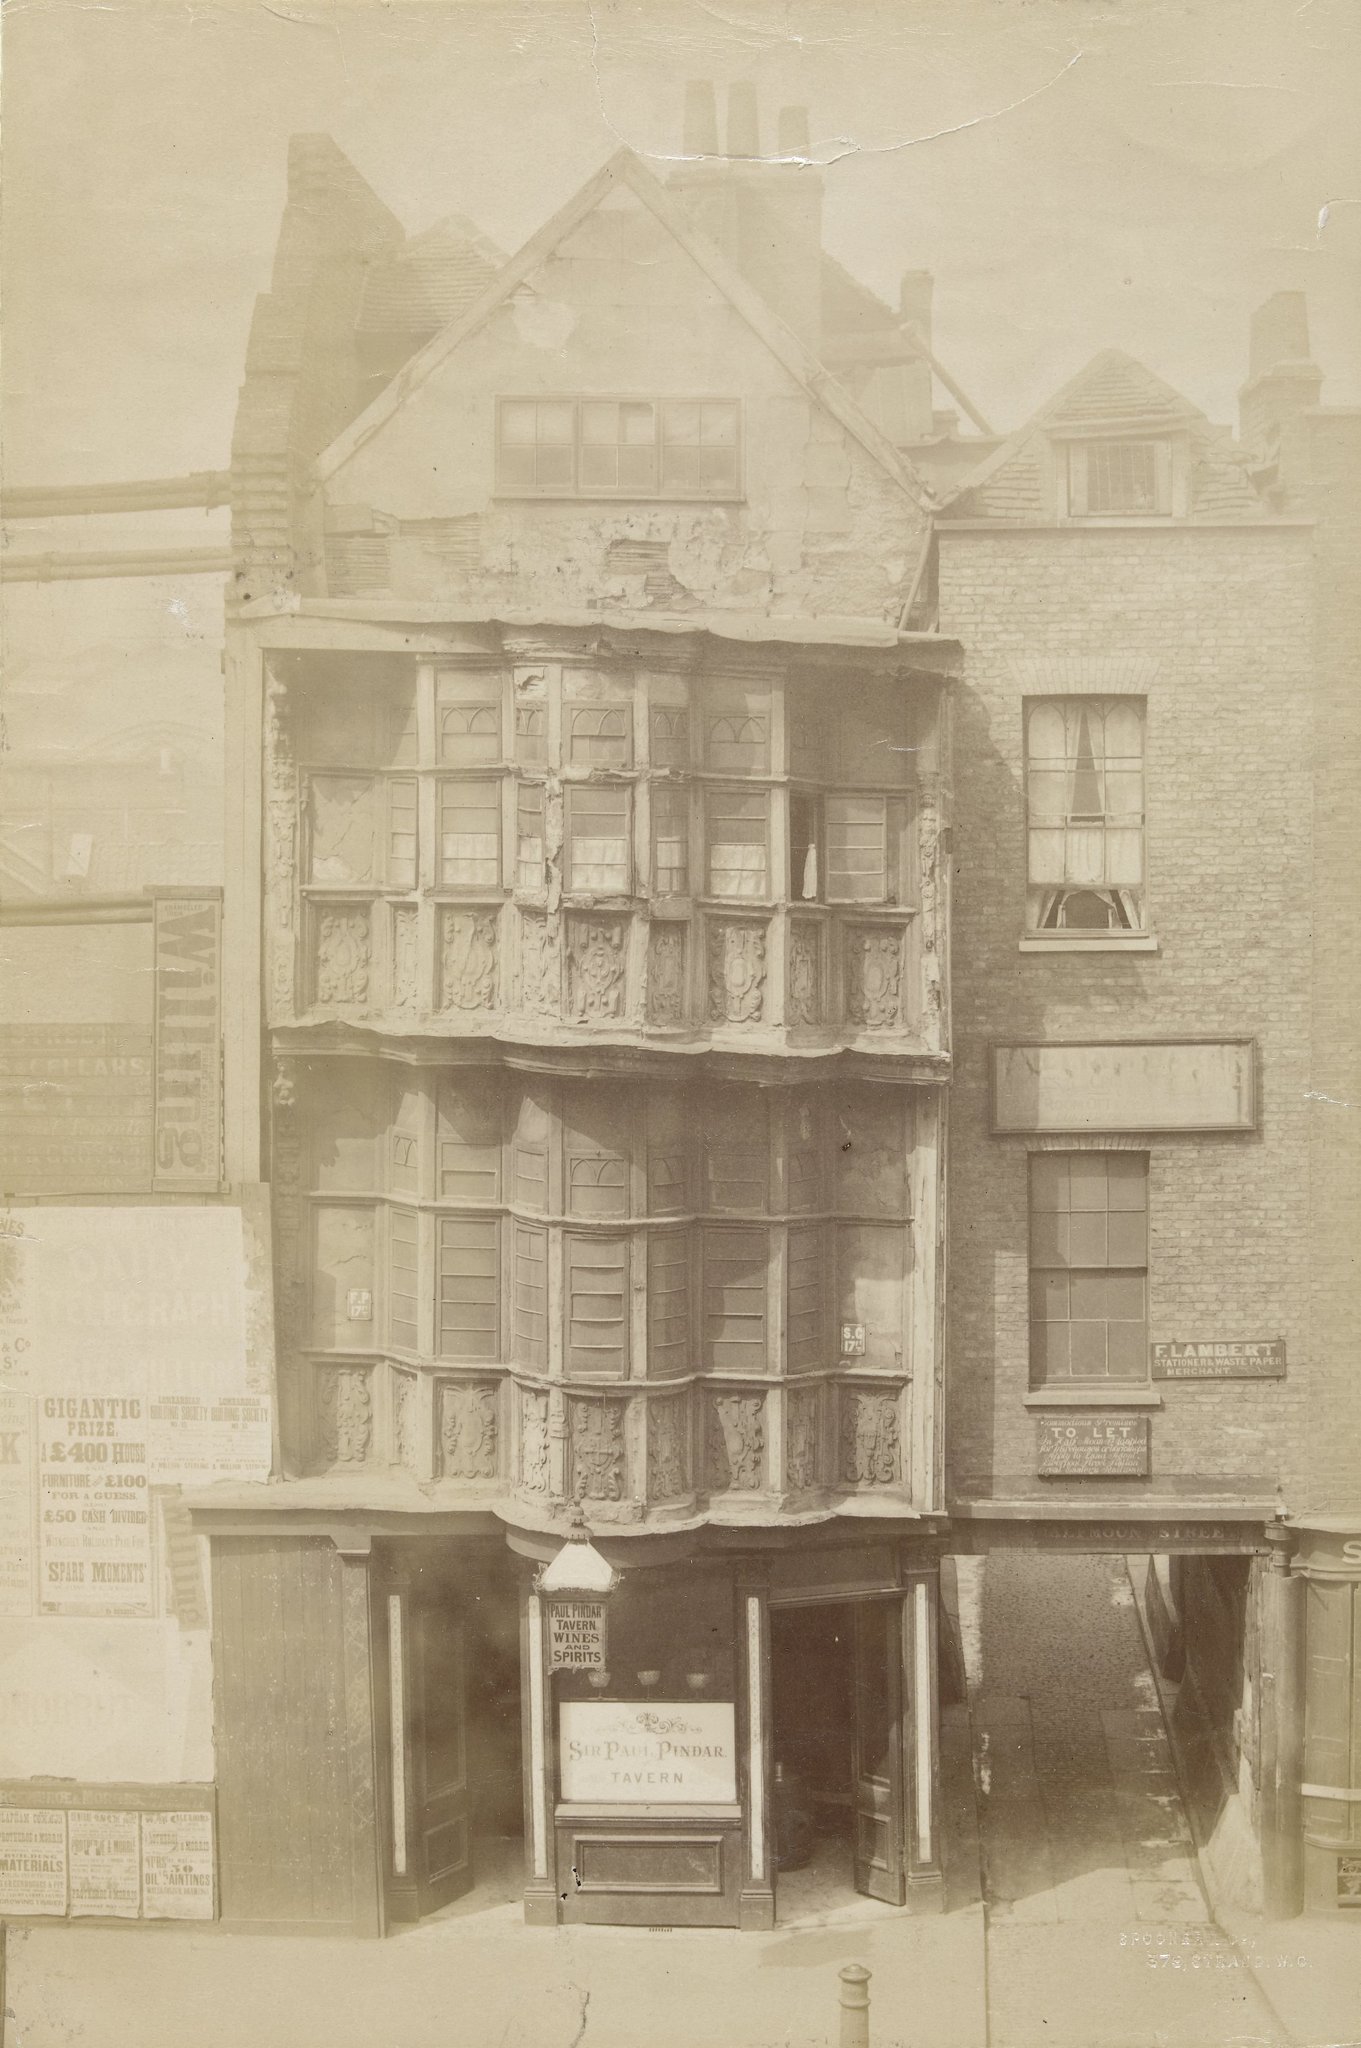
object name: photograph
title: Voorgevel huis [in Holborn, Londen?]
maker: w.m. spooner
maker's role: fotograaf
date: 1870-1890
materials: cardboard, paper, photographic support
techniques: albumen print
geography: great britain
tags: house combined with shop, london